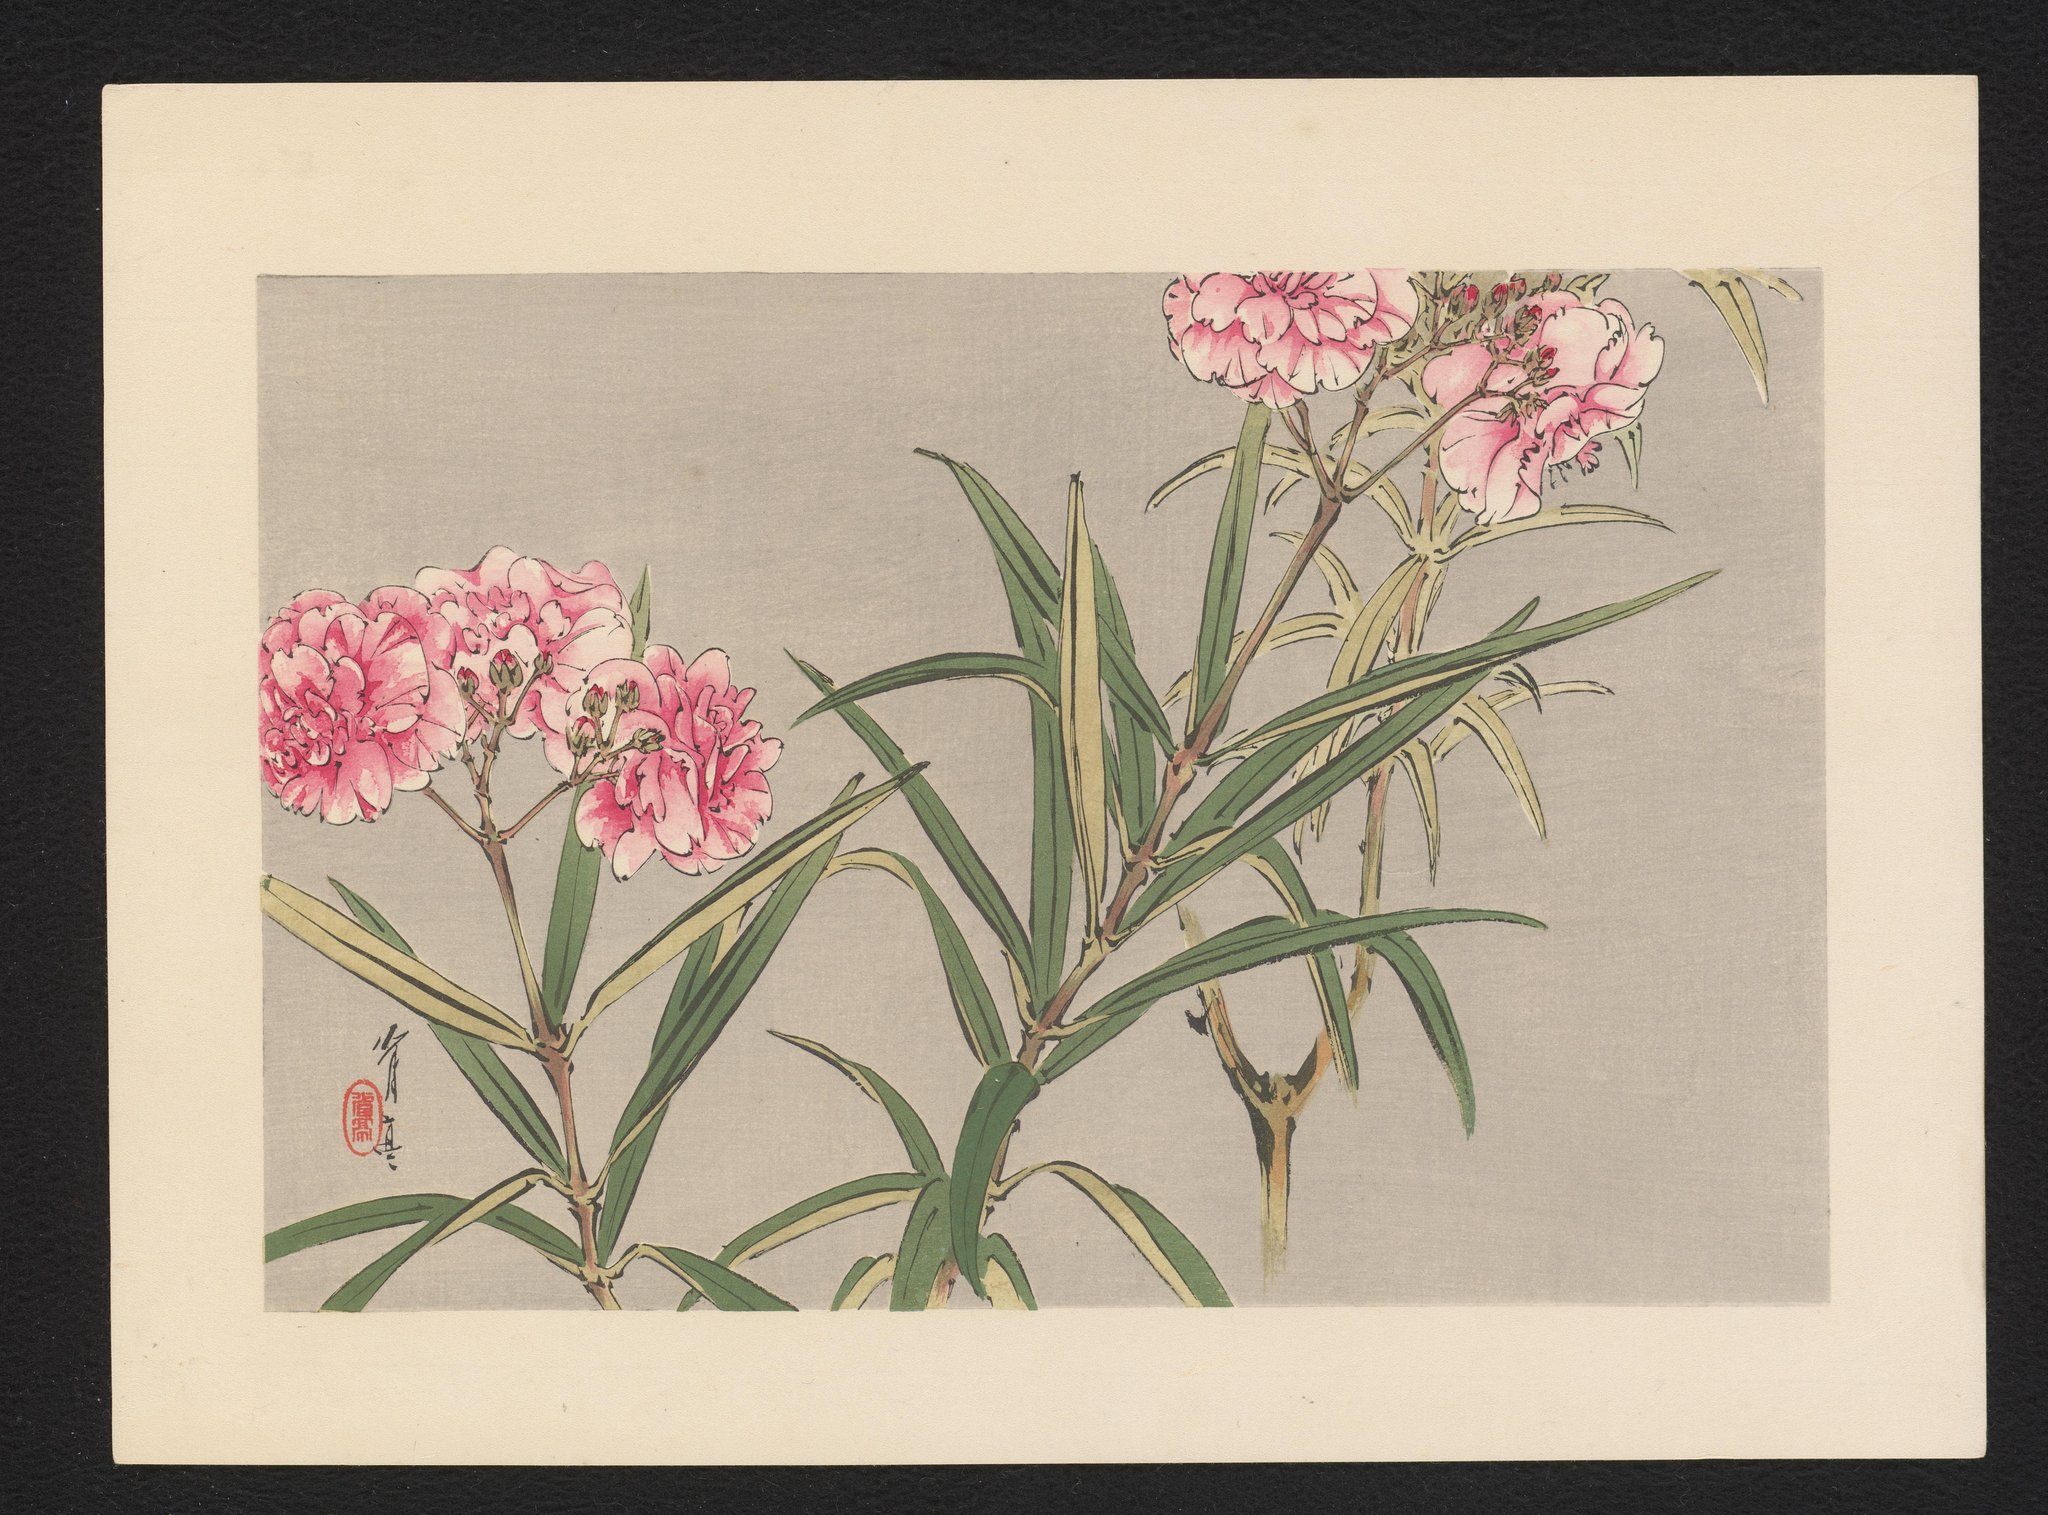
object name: print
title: Bloeiende oleander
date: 1916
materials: paper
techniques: woodcut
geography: japan